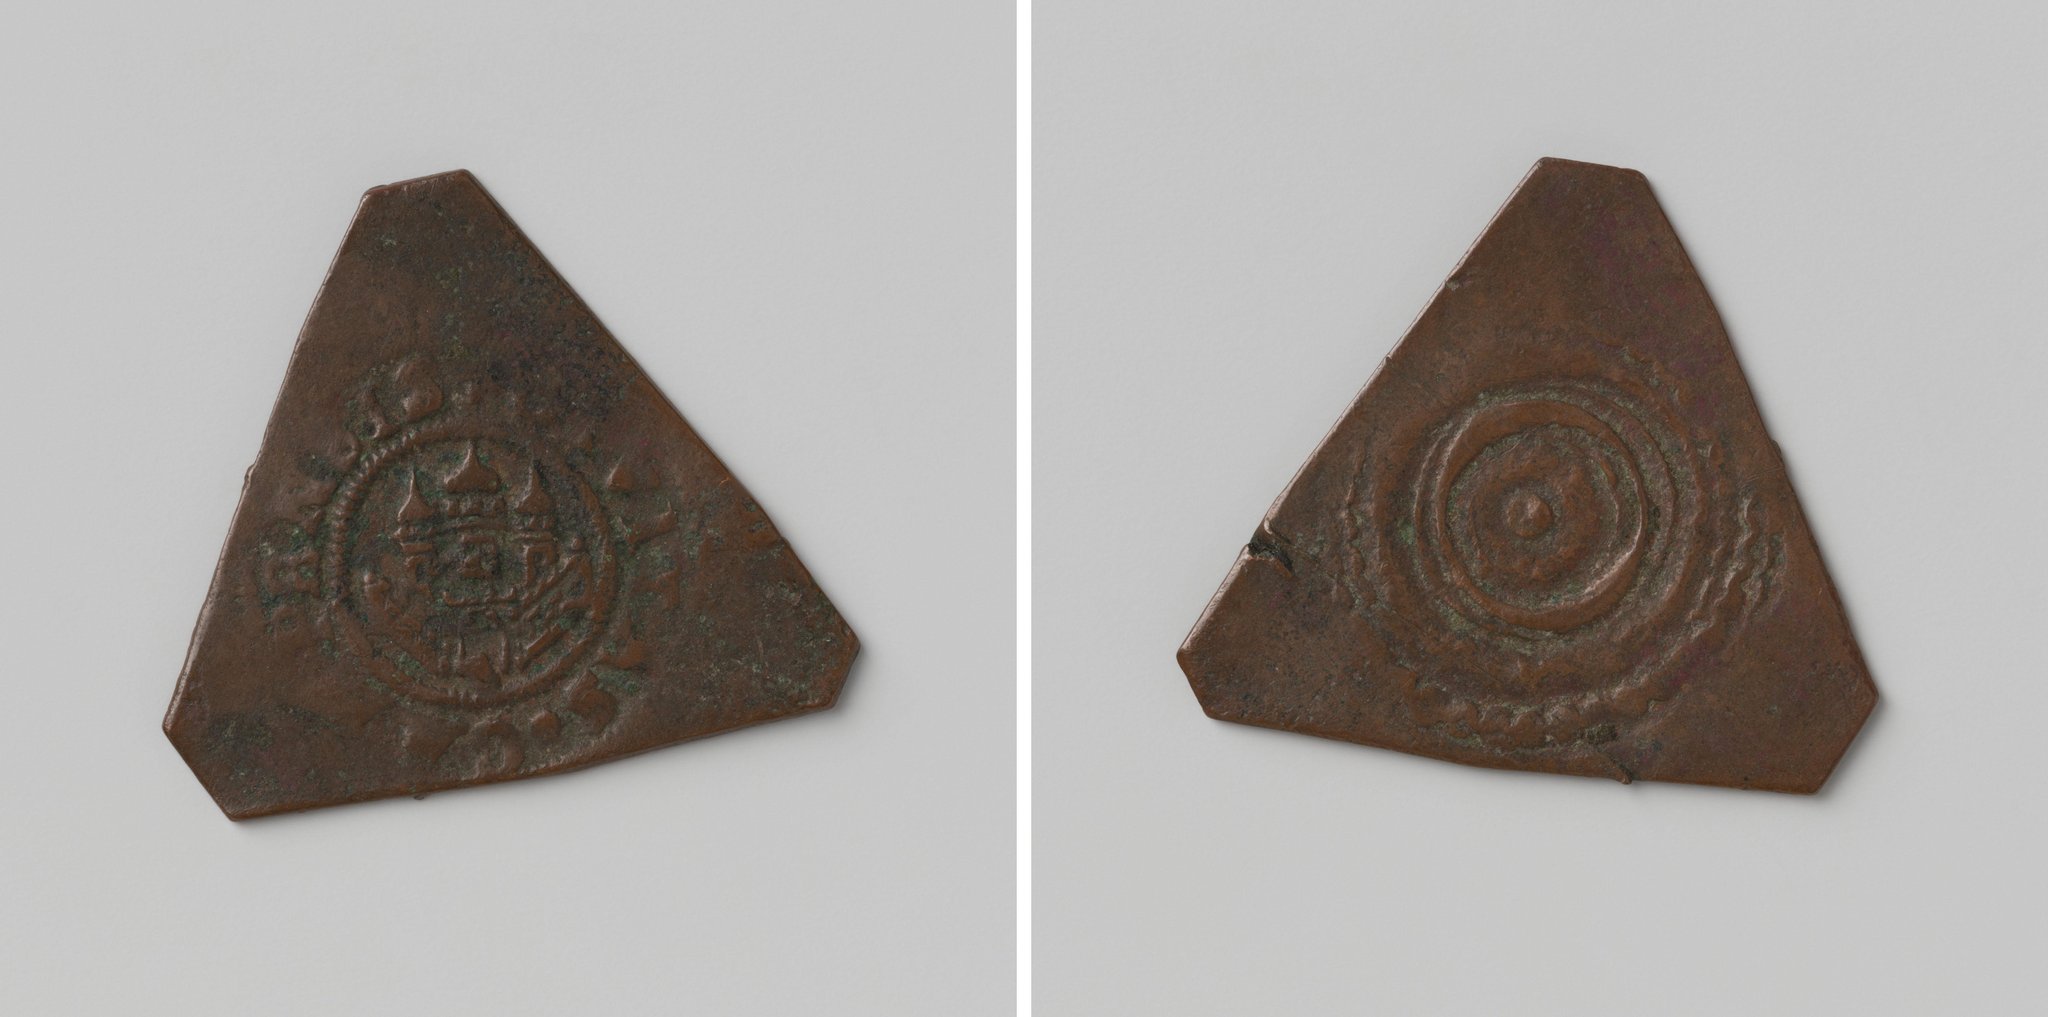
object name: bread token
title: Armenpenning van de stad Kampen, die bij uitdeling recht gaf op brood of graan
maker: Anonymous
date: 1600-1700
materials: copper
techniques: striking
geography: kampen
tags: kampen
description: Koperen driehoekige penning met afgeschuinde hoeken. Voorzijde: in ronde stempel: burcht binnen omschrift. Keerzijde: aantal concentrische cirkels met in midden letter O [?].